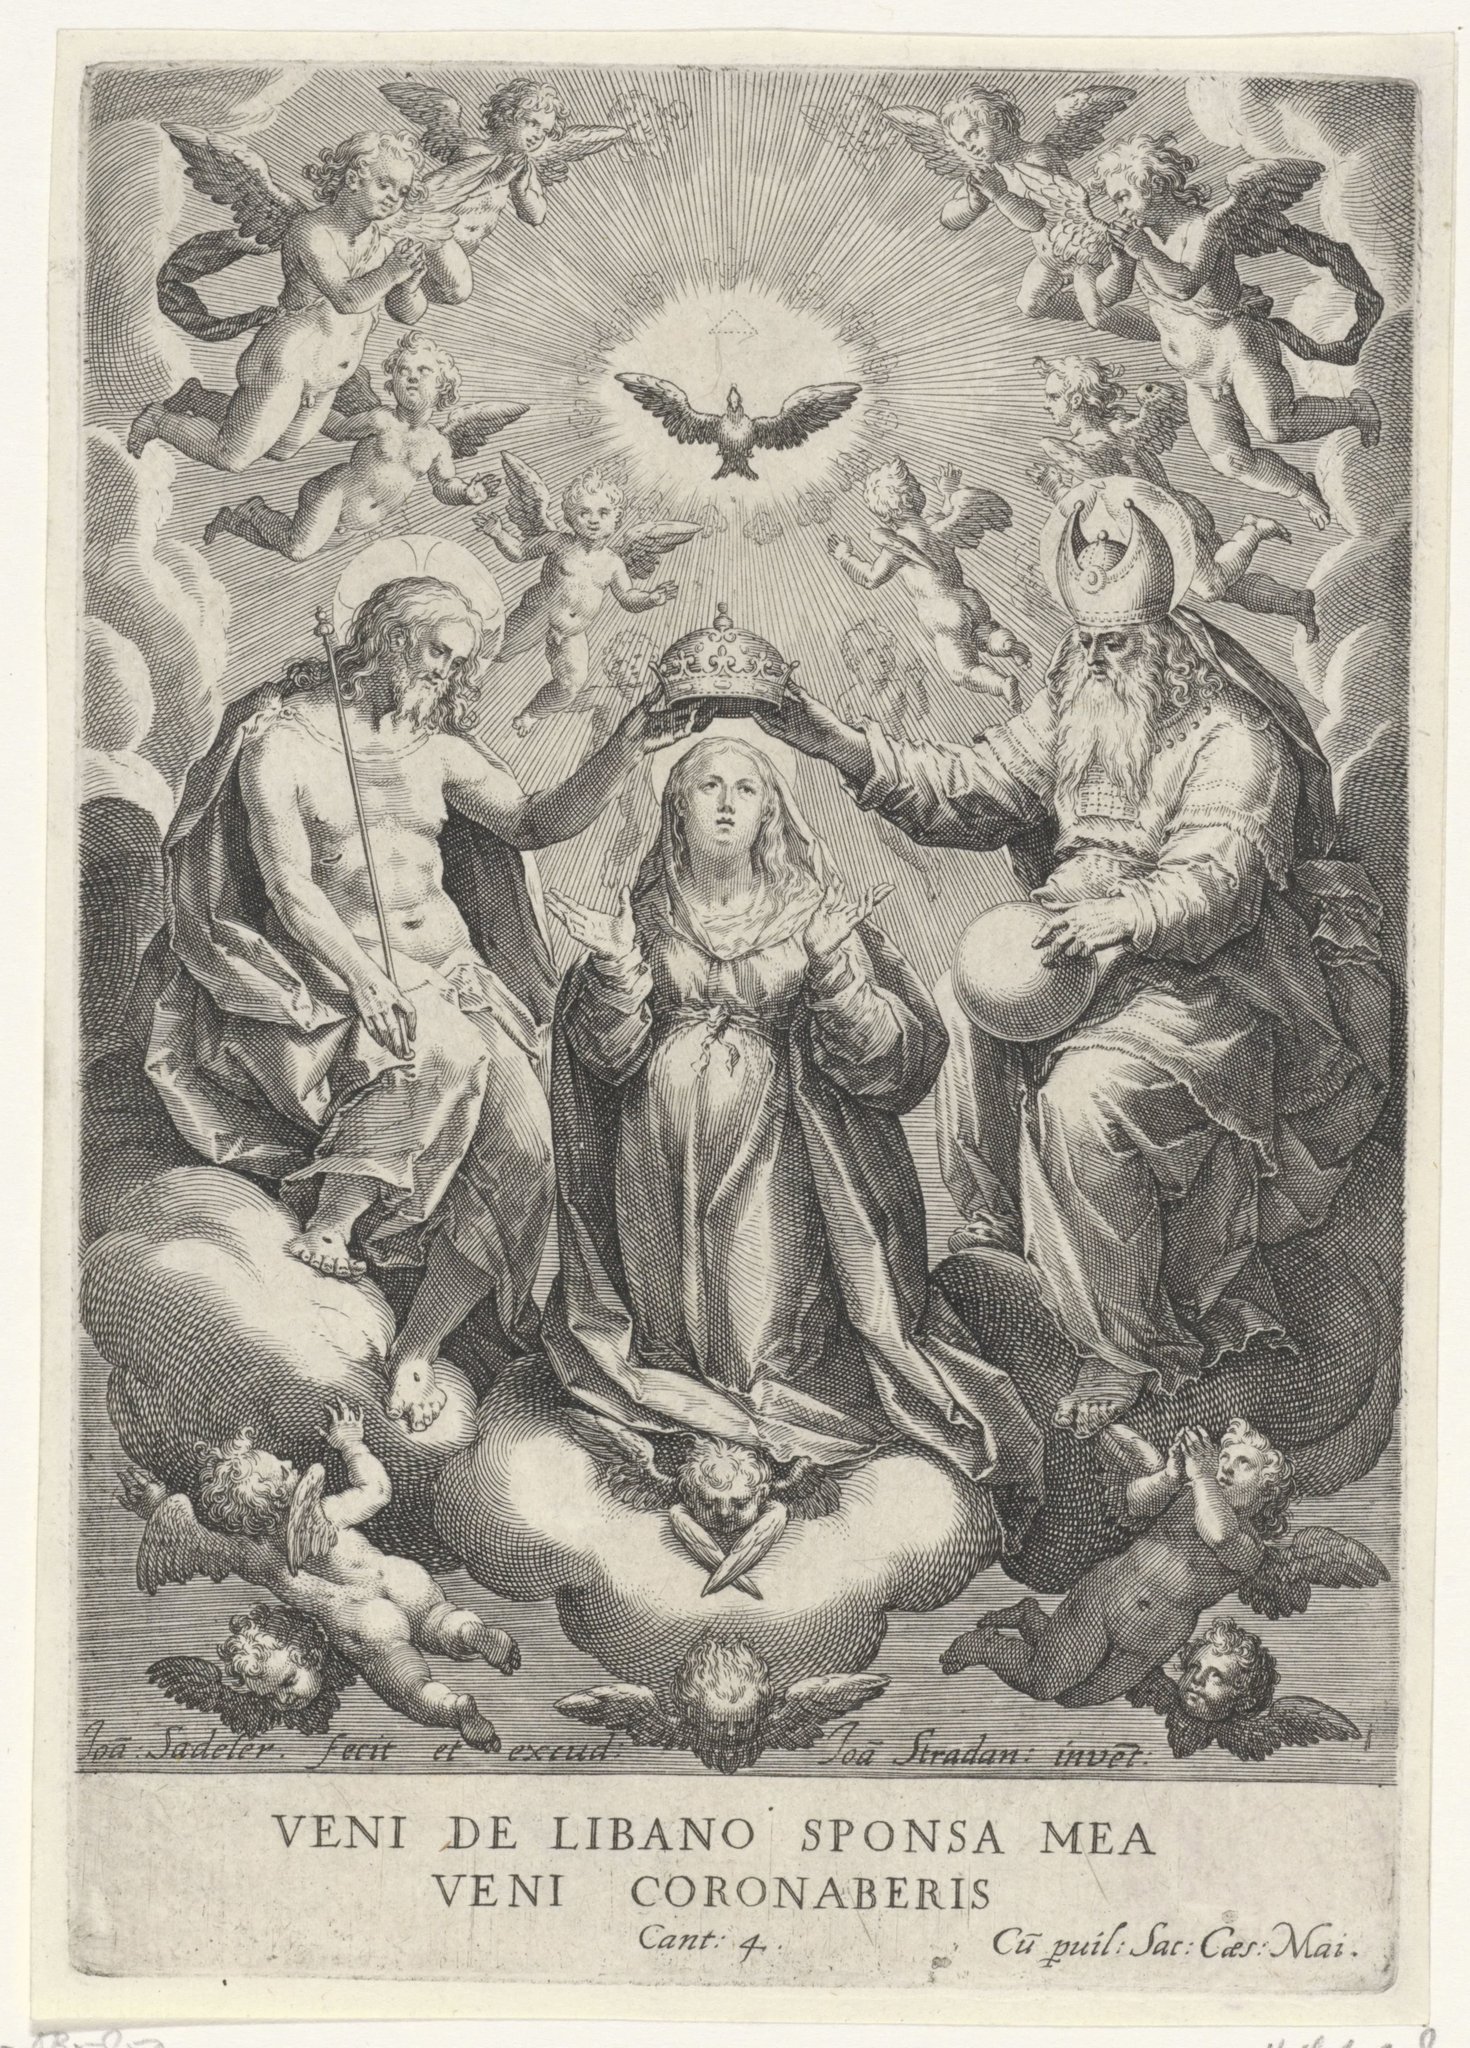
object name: print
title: Kroning van Maria met engelenscharen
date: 1593-1600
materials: paper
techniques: engraving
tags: coronation of mary in heaven (usually the holy trinity present) (+ angel(s))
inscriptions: collector's mark: Lugt 240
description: De kroning van Maria in de wolken. God de Vader en Christus houden de kroon boven haar hoofd. In het midden de Heilige Geest als duif. Rondom de Heilige drieënheid vliegende engelen.